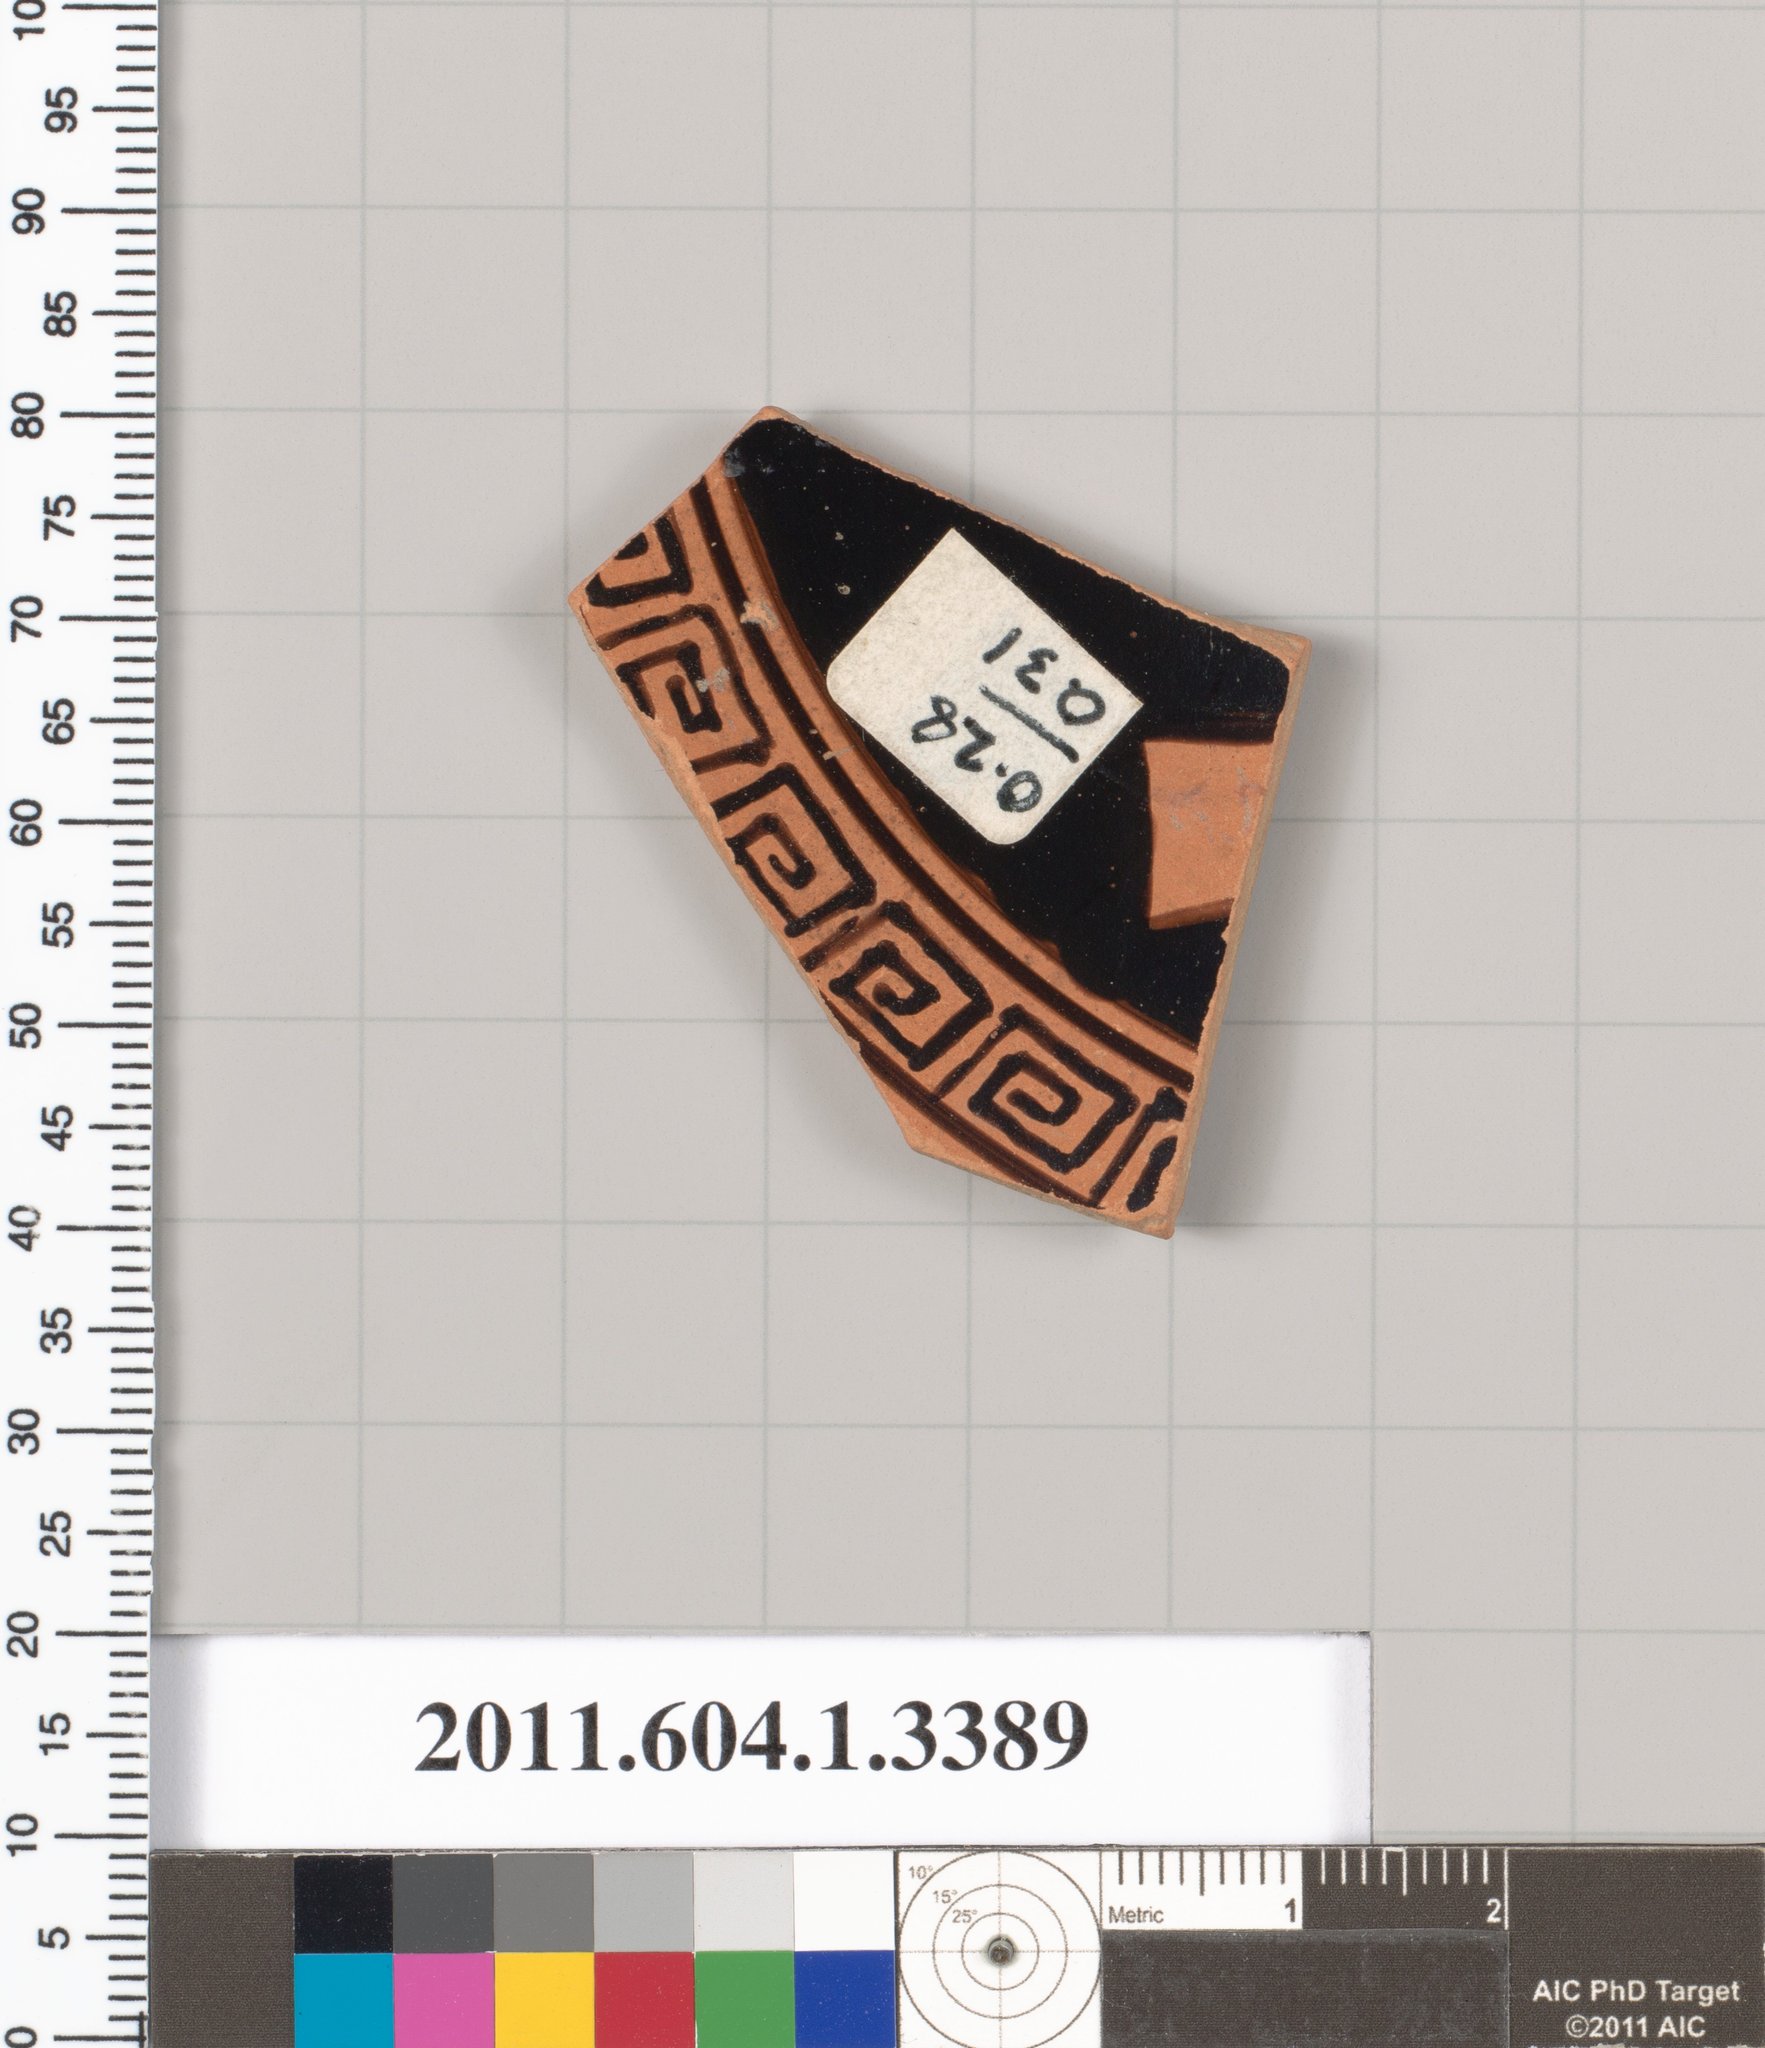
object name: kylix fragment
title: Terracotta fragment of a kylix (drinking cup)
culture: greek, attic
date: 475-451 BCE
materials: terracotta